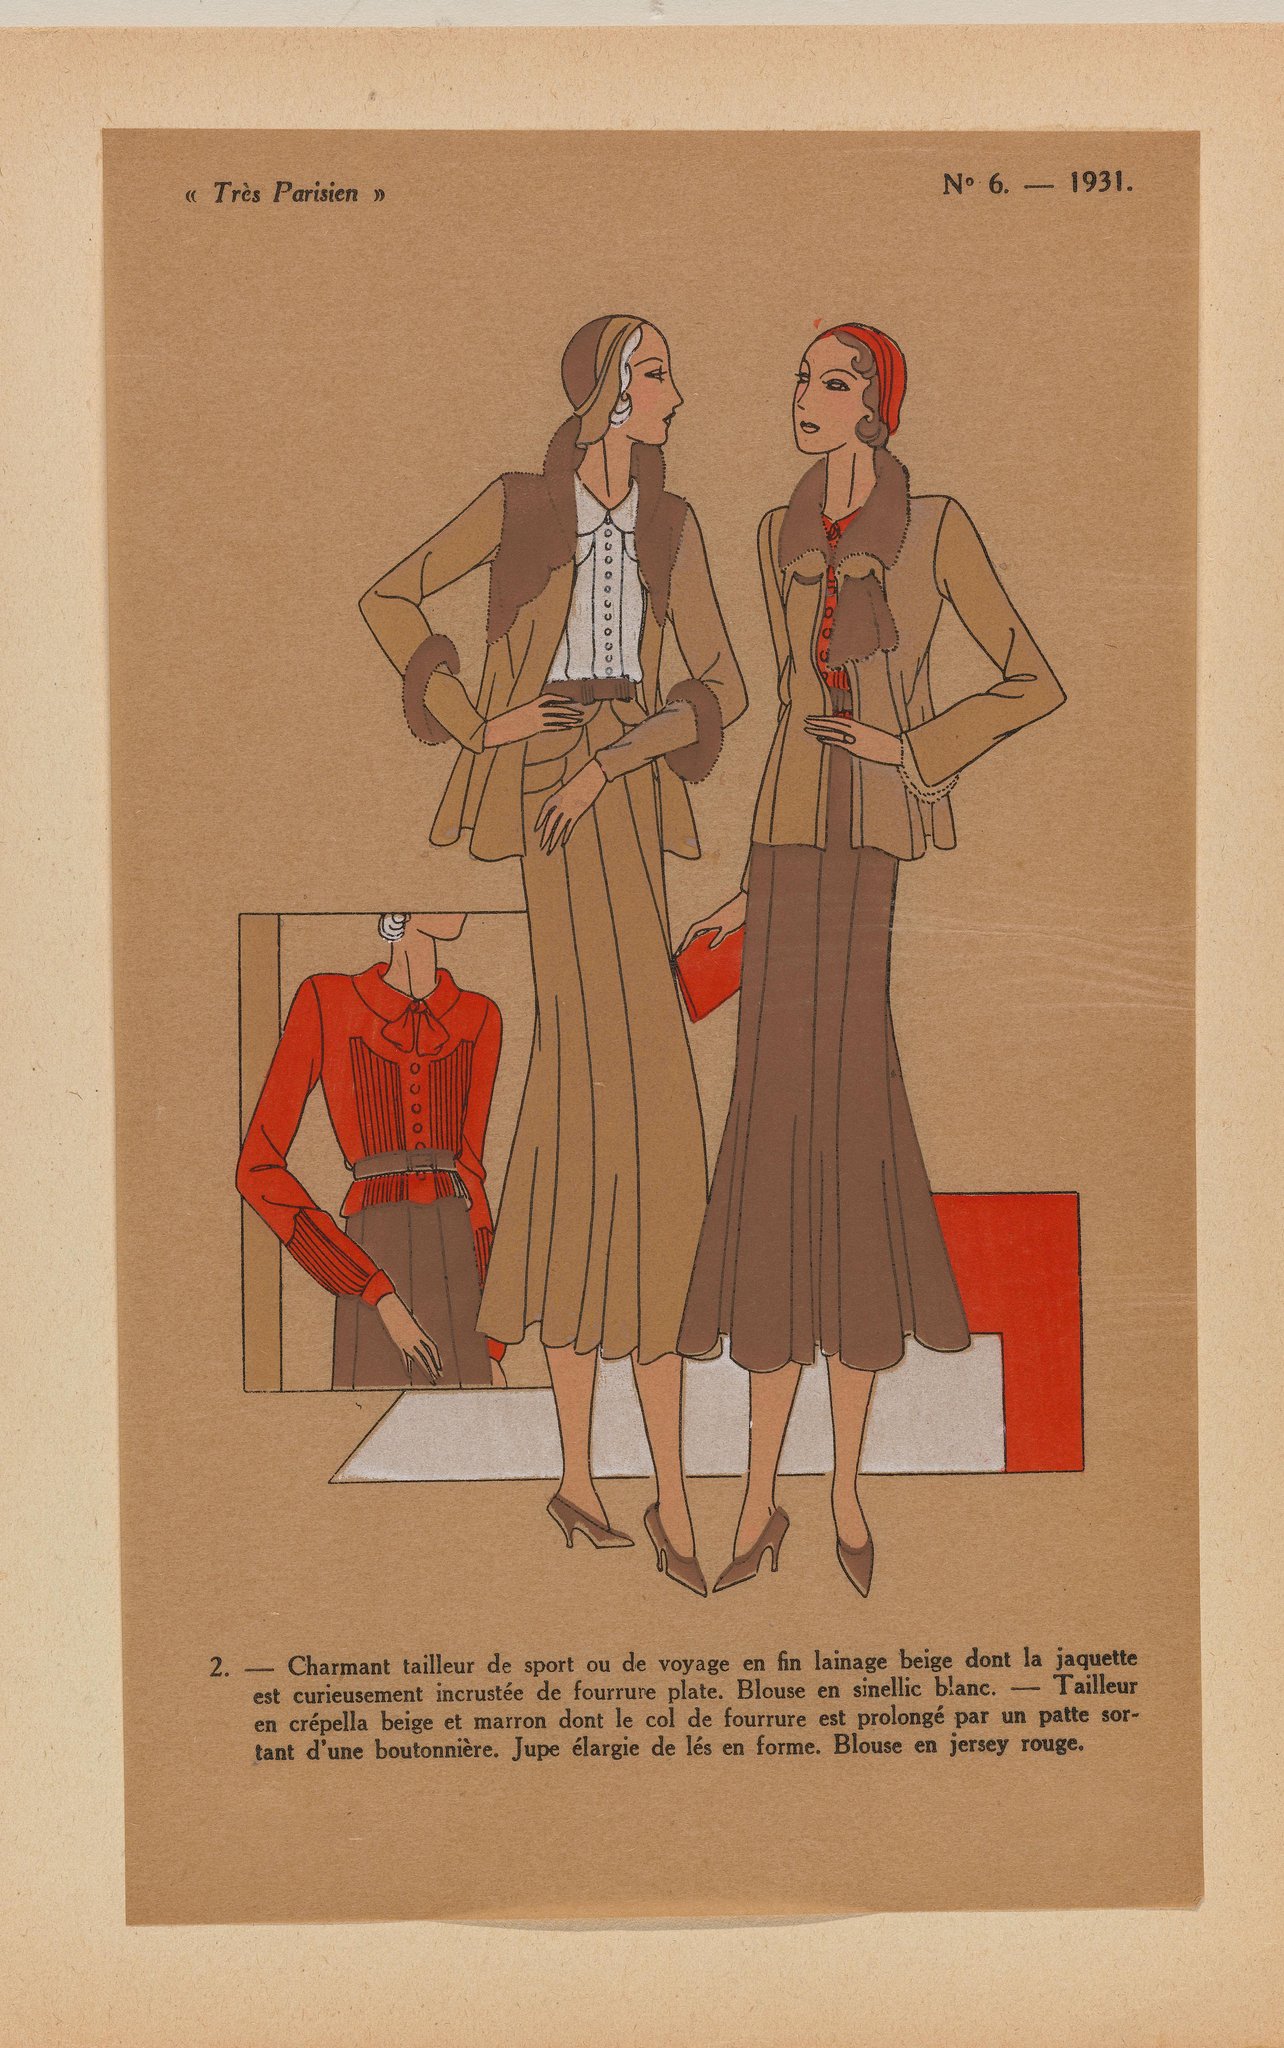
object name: fashion print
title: Très Parisien. La Mode, Le Chic, L’Elégance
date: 1931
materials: paper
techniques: hand coloring, letterpress printing, lithography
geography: paris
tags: clothing for the upper part of the body: blouse (+ women's clothes), ensembles of pieces of clothing (suit) (+ women's clothes), head-gear: beret (+ women's clothes), bag (handbag) (+ women's clothes), coat (+ women's clothes), clothes, costume (+ women's clothes), skirt (+ women's clothes), neck-gear: collar (+ fur used for clothes)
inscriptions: title: ‘"Très Parisien" / No 6. - 1931’, caption: ‘2. - Charmant tailleur de sport ou de voyage en fin lainage beige dont la jaquette est curieusement incrustée de fourrure plate. Blouse en sinellic blanc. - Tailleur en crépella beige et marron dont le col de fourrure est prolongé par un patte sortant d'une boutonnière. Jupe élargie de lés en forme. Blouse en jersey rouge.’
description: Très Parisien promoted itself as chic and elegant. Between 1920 and 1936 it presented creations by such couturiers as Chéruit, Premet, Philip et Gaston, and Lanvin. The young, svelte models are all ultra-modern, shown talking on the phone, smoking and playing tennis. The illustrations also show that over the course of the 1920s, skirt lengths had risen to just below the knee, before dropping back down to calf length in the 1930s. The small plates were printed on transparent paper using a stencilling technique known as en pochoir and then hand coloured; many of them are unsigned. The signature ‘Joujou’ belonged to Germaine Paule Joumard, who was the director of Très Parisien, as well as one of the magazine’s illustrators.